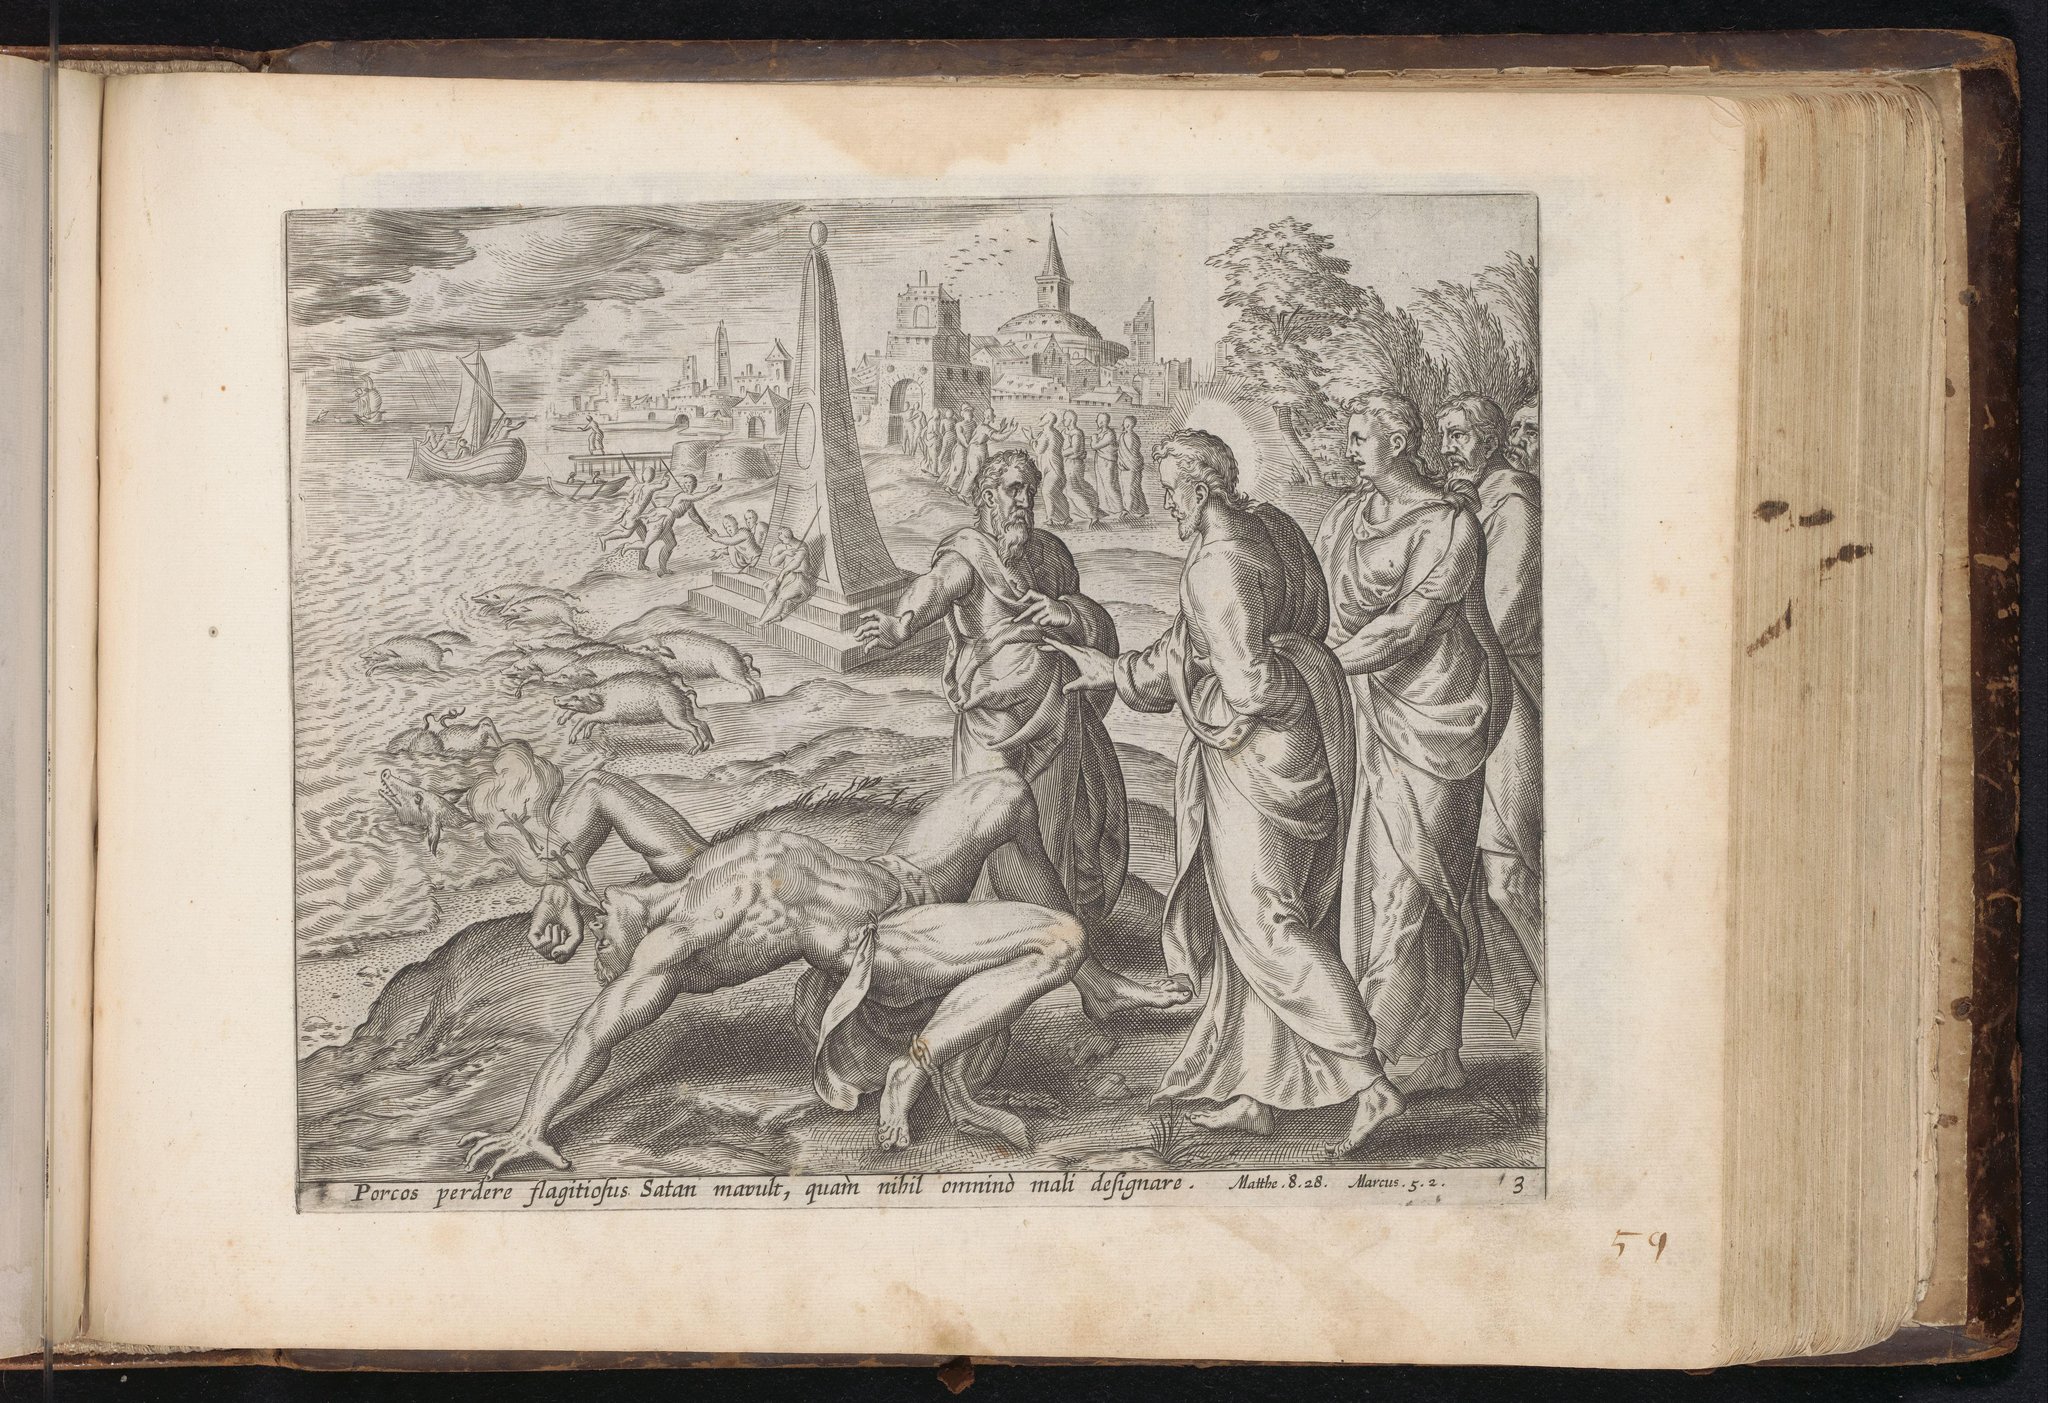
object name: album leaf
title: Den Grooten Figuer-Bibel (...)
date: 1572-1576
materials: paper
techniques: engraving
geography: alkmaar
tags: the demons enter into a herd of swine, which leap into the sea ~ healing of two possessed at gerasa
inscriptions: number: ‘59’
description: Christus geneest een bezeten man in het gebied van de Gerasenen. De onreine geesten verlaten de man via zijn mond en trekken in een kudde varkens, die het meer inrennen en verdrinken. De discipelen van Christus kijken toe. Op de achtergrond is het vervolg van het verhaal verbeeld: De varkenshoeders slaan op de vlucht en vertellen in de stad wat er is gebeurd. Daarop komen de bewoners naar Christus en vragen hem hun gebied te verlaten. Links op de achtergrond vertrekt Christus in een boot en blijft de genezen man achter op de steiger. Onder de voorstelling een verwijzing in het Latijn naar de Bijbeltekst in Mat. 8:28 en Mar. 5:2. Deze prent maakt deel uit van een album.